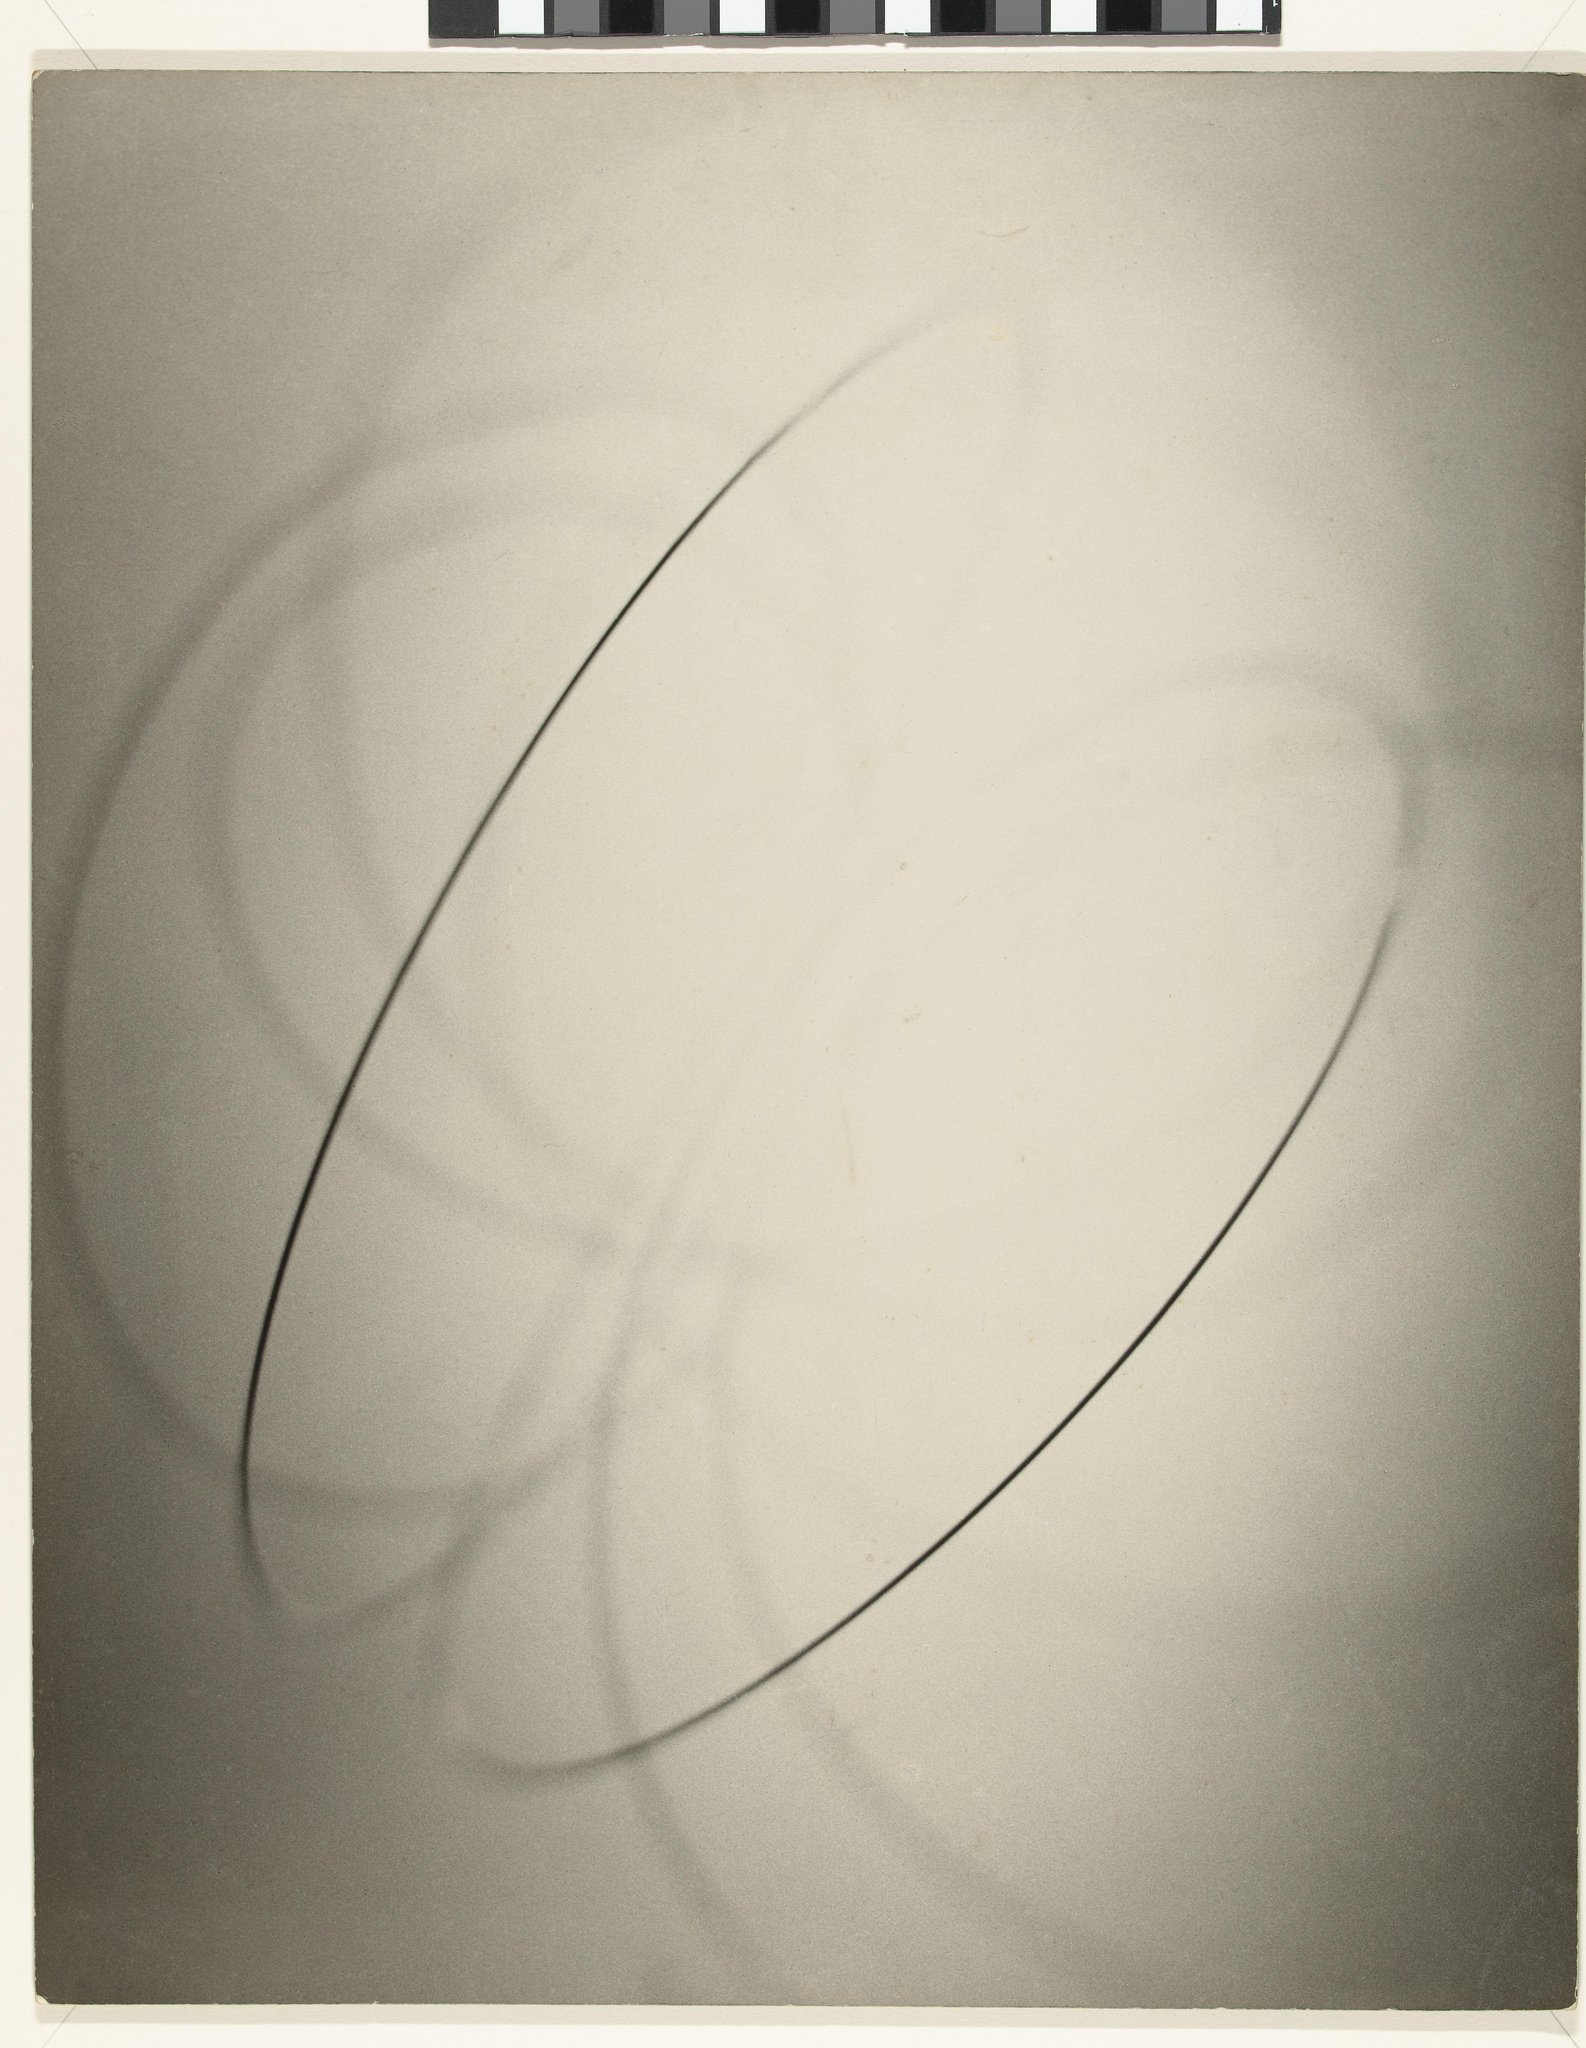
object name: photograph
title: Abstract Composition (Luminogram)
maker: pim van os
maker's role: fotograaf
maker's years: 1910-1954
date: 1952-1953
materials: cardboard, photographic support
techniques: gelatin silver print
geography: netherlands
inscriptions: stamp: ‘foto pim van os’, stamp: ‘ZOLL I-11 +’, stamp: ‘V. SITUATIEPOST LEIDEN’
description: In the course of the 20th century photographers increasingly abandoned the idea that they had to reproduce visible reality. The desire for radical and absolute abstraction led to all kinds of experiments with light and movement.